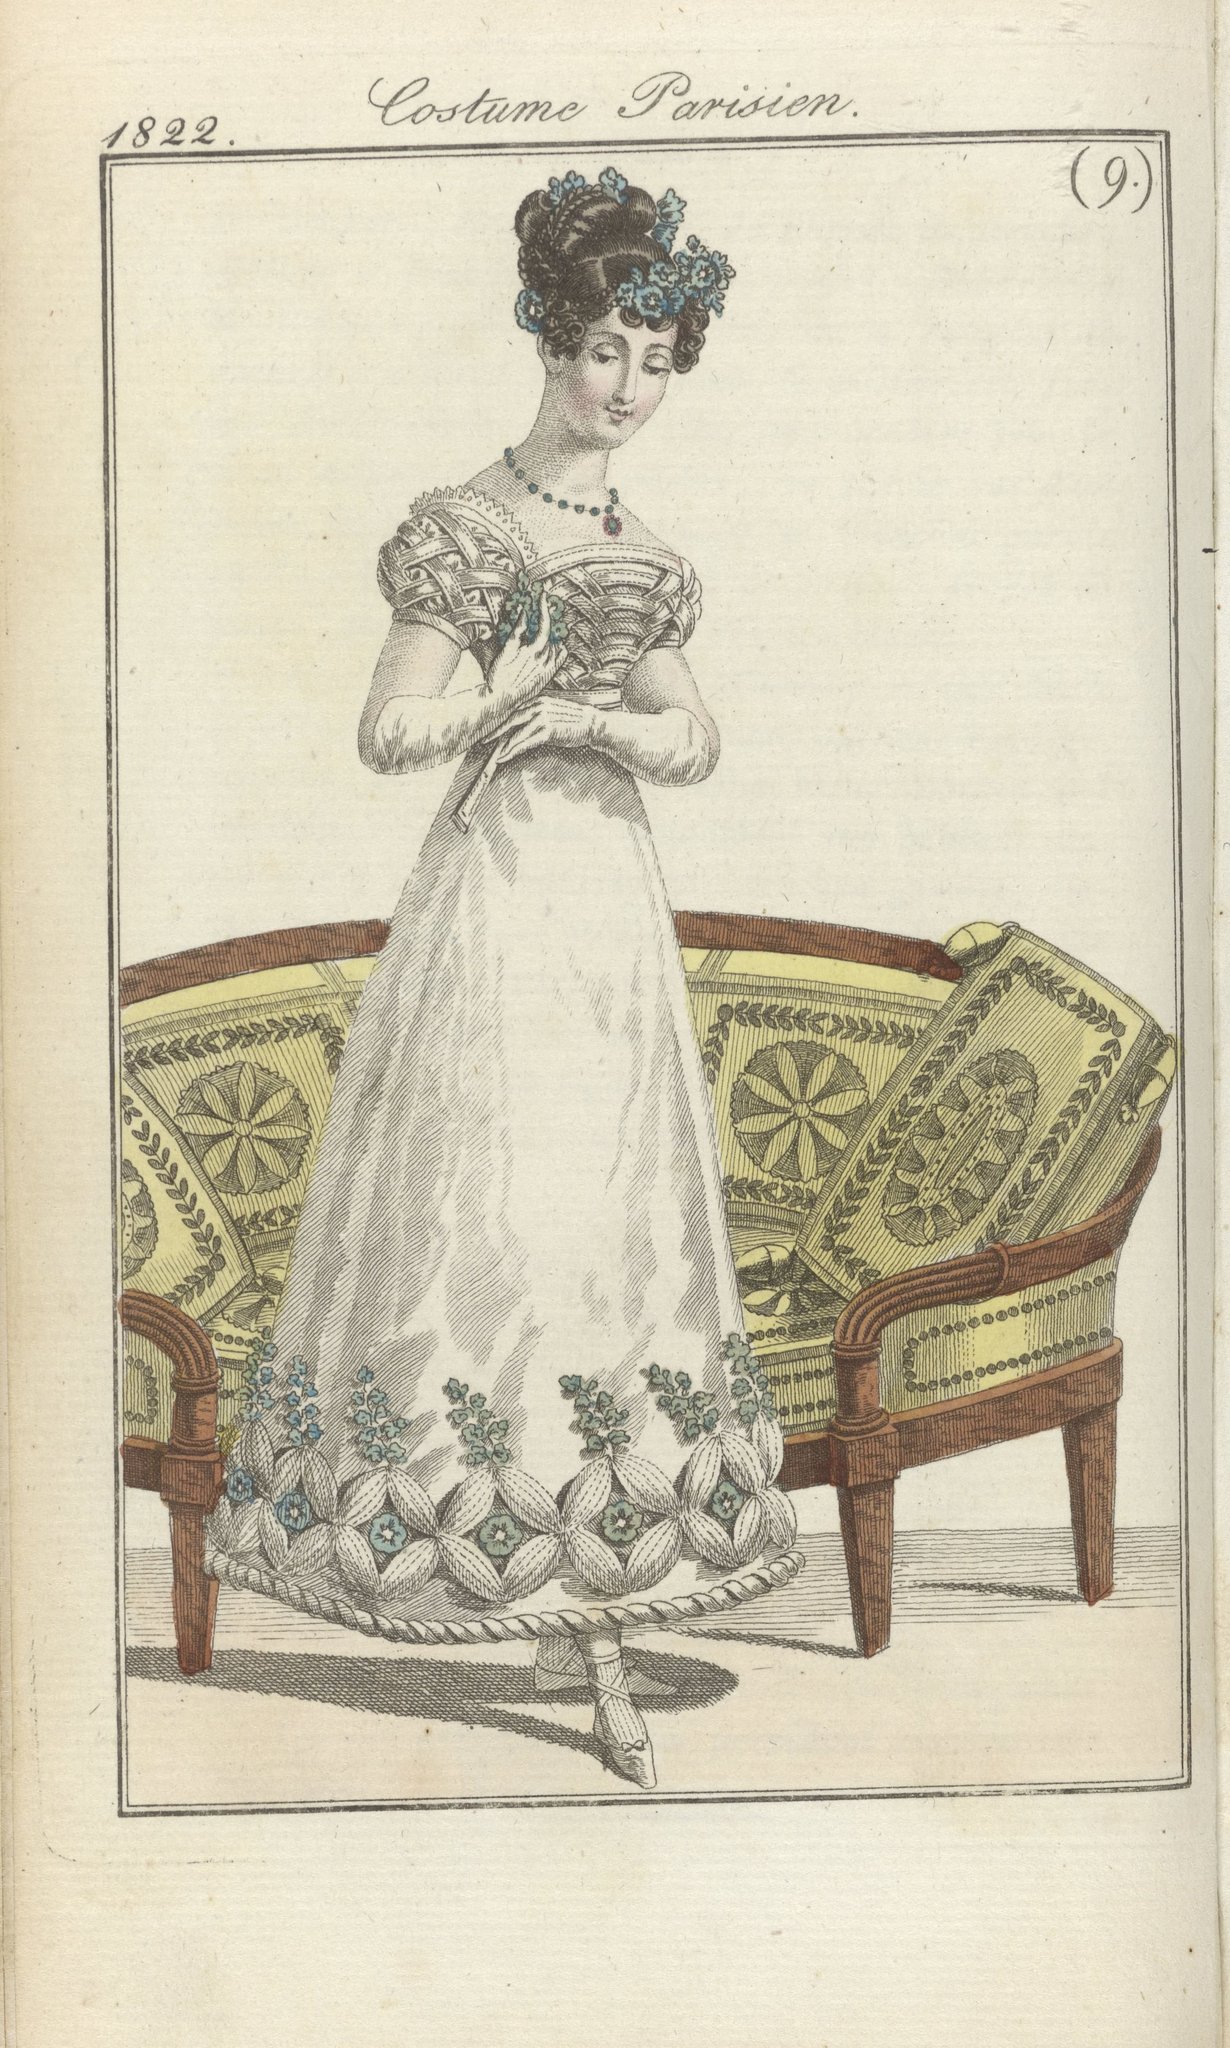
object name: fashion print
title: Journal des Dames et des Modes, editie Frankfurt 24 février 1822, Costume Parisien (9)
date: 1822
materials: paper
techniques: engraving, hand coloring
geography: frankfurt am main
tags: flowers, pendant, trinket, 'breloque' (+ women's clothes), gloves, mittens (long gloves) (+ women's clothes), styles of hairdress - aa - ~ women, fashion plates, shoes, sandals (+ women's clothes), dress, gown (+ women's clothes), fan (+ women's clothes), couch, sofa, settee, clothing for the upper part of the body (with name) (+ women's clothes)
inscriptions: date: ‘1822’, title: ‘Costume Parisien. (9.)’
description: De begeleidende tekst (p. 240) vermeldt: Kapsel met bloemen en parels(of kralen) Japon met lijfje en mouwen 'en corbeille'. Witte handschoenen. Witte schoenen. Op de achtergrond een canapé van mahoniehout. De prent maakt deel uit van het modetijdschrift Journal des Dames et des Modes, uitgegeven in Frankfurt als kopie van de Franse editie van Pierre de la Mésangère, Parijs, 1797-1839.